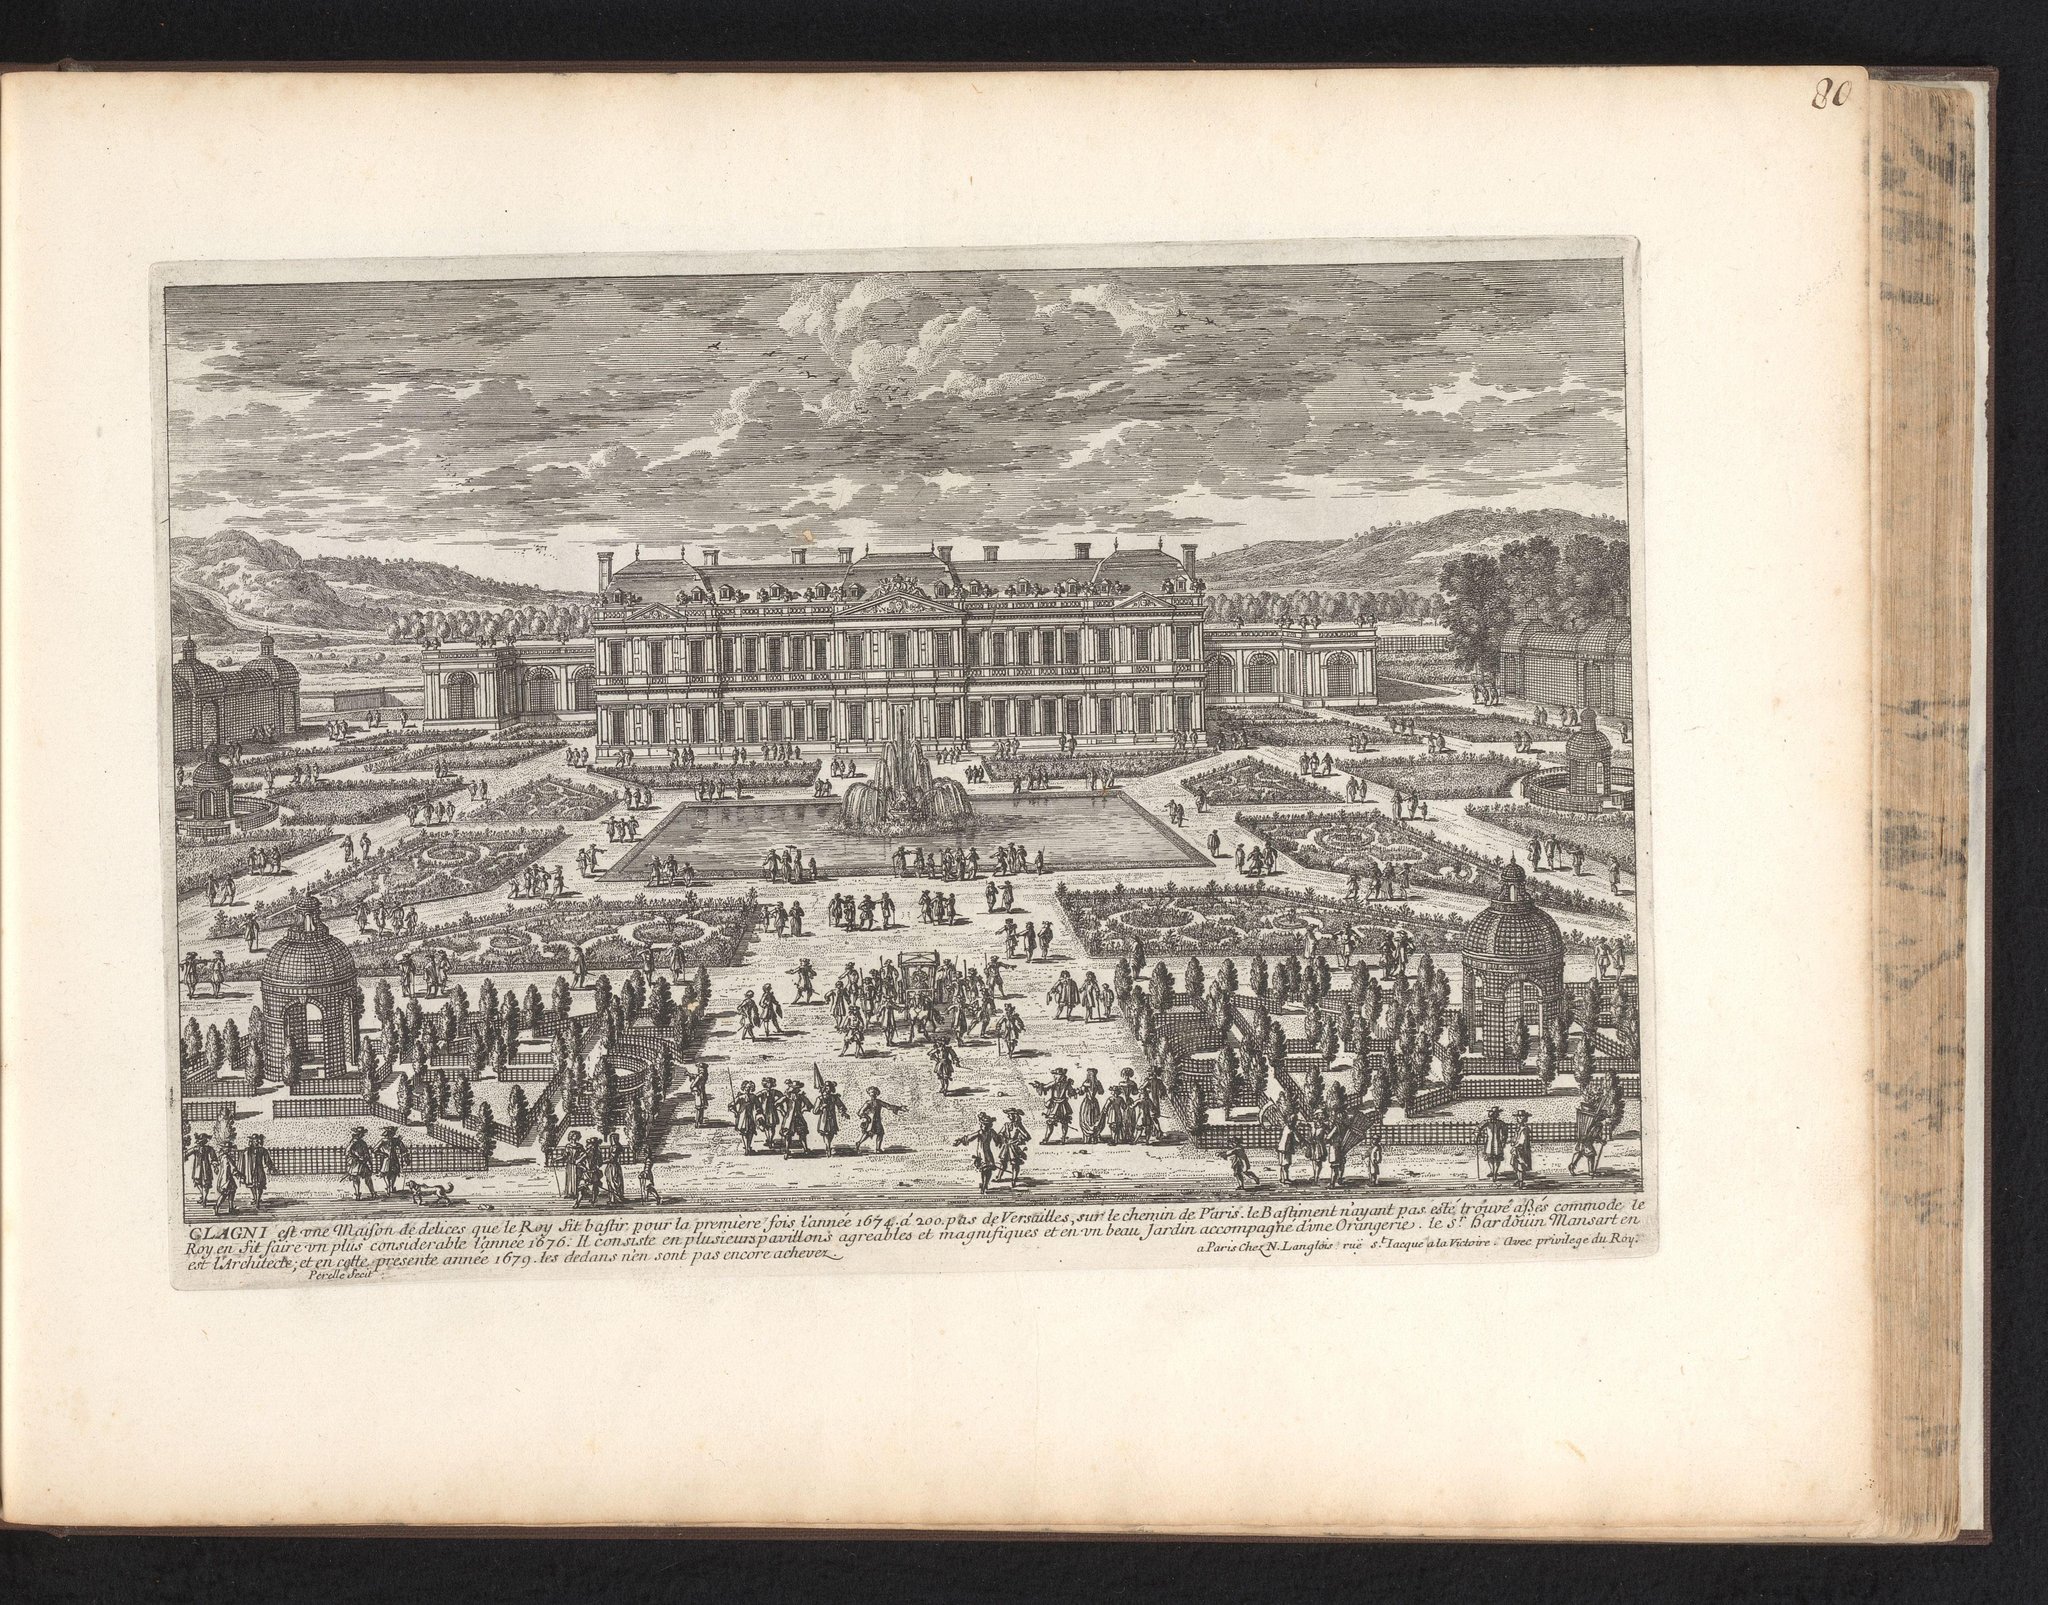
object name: album leaf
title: Glagni est une Maison de delices (...)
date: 1679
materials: paper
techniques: etching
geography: france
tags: garden fountain, french or architectonic garden; formal garden, country-house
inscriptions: collector's mark: Lugt 2228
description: Prenten met het signatuur 'Perelle' kunnen zowel door vader Gabriel als door zonen Nicolas en Adam gemaakt zijn. De uitgevers vader en zoon Nicolas Langlois worden allebei vermeld als N. Langlois op hetzelfde adres.